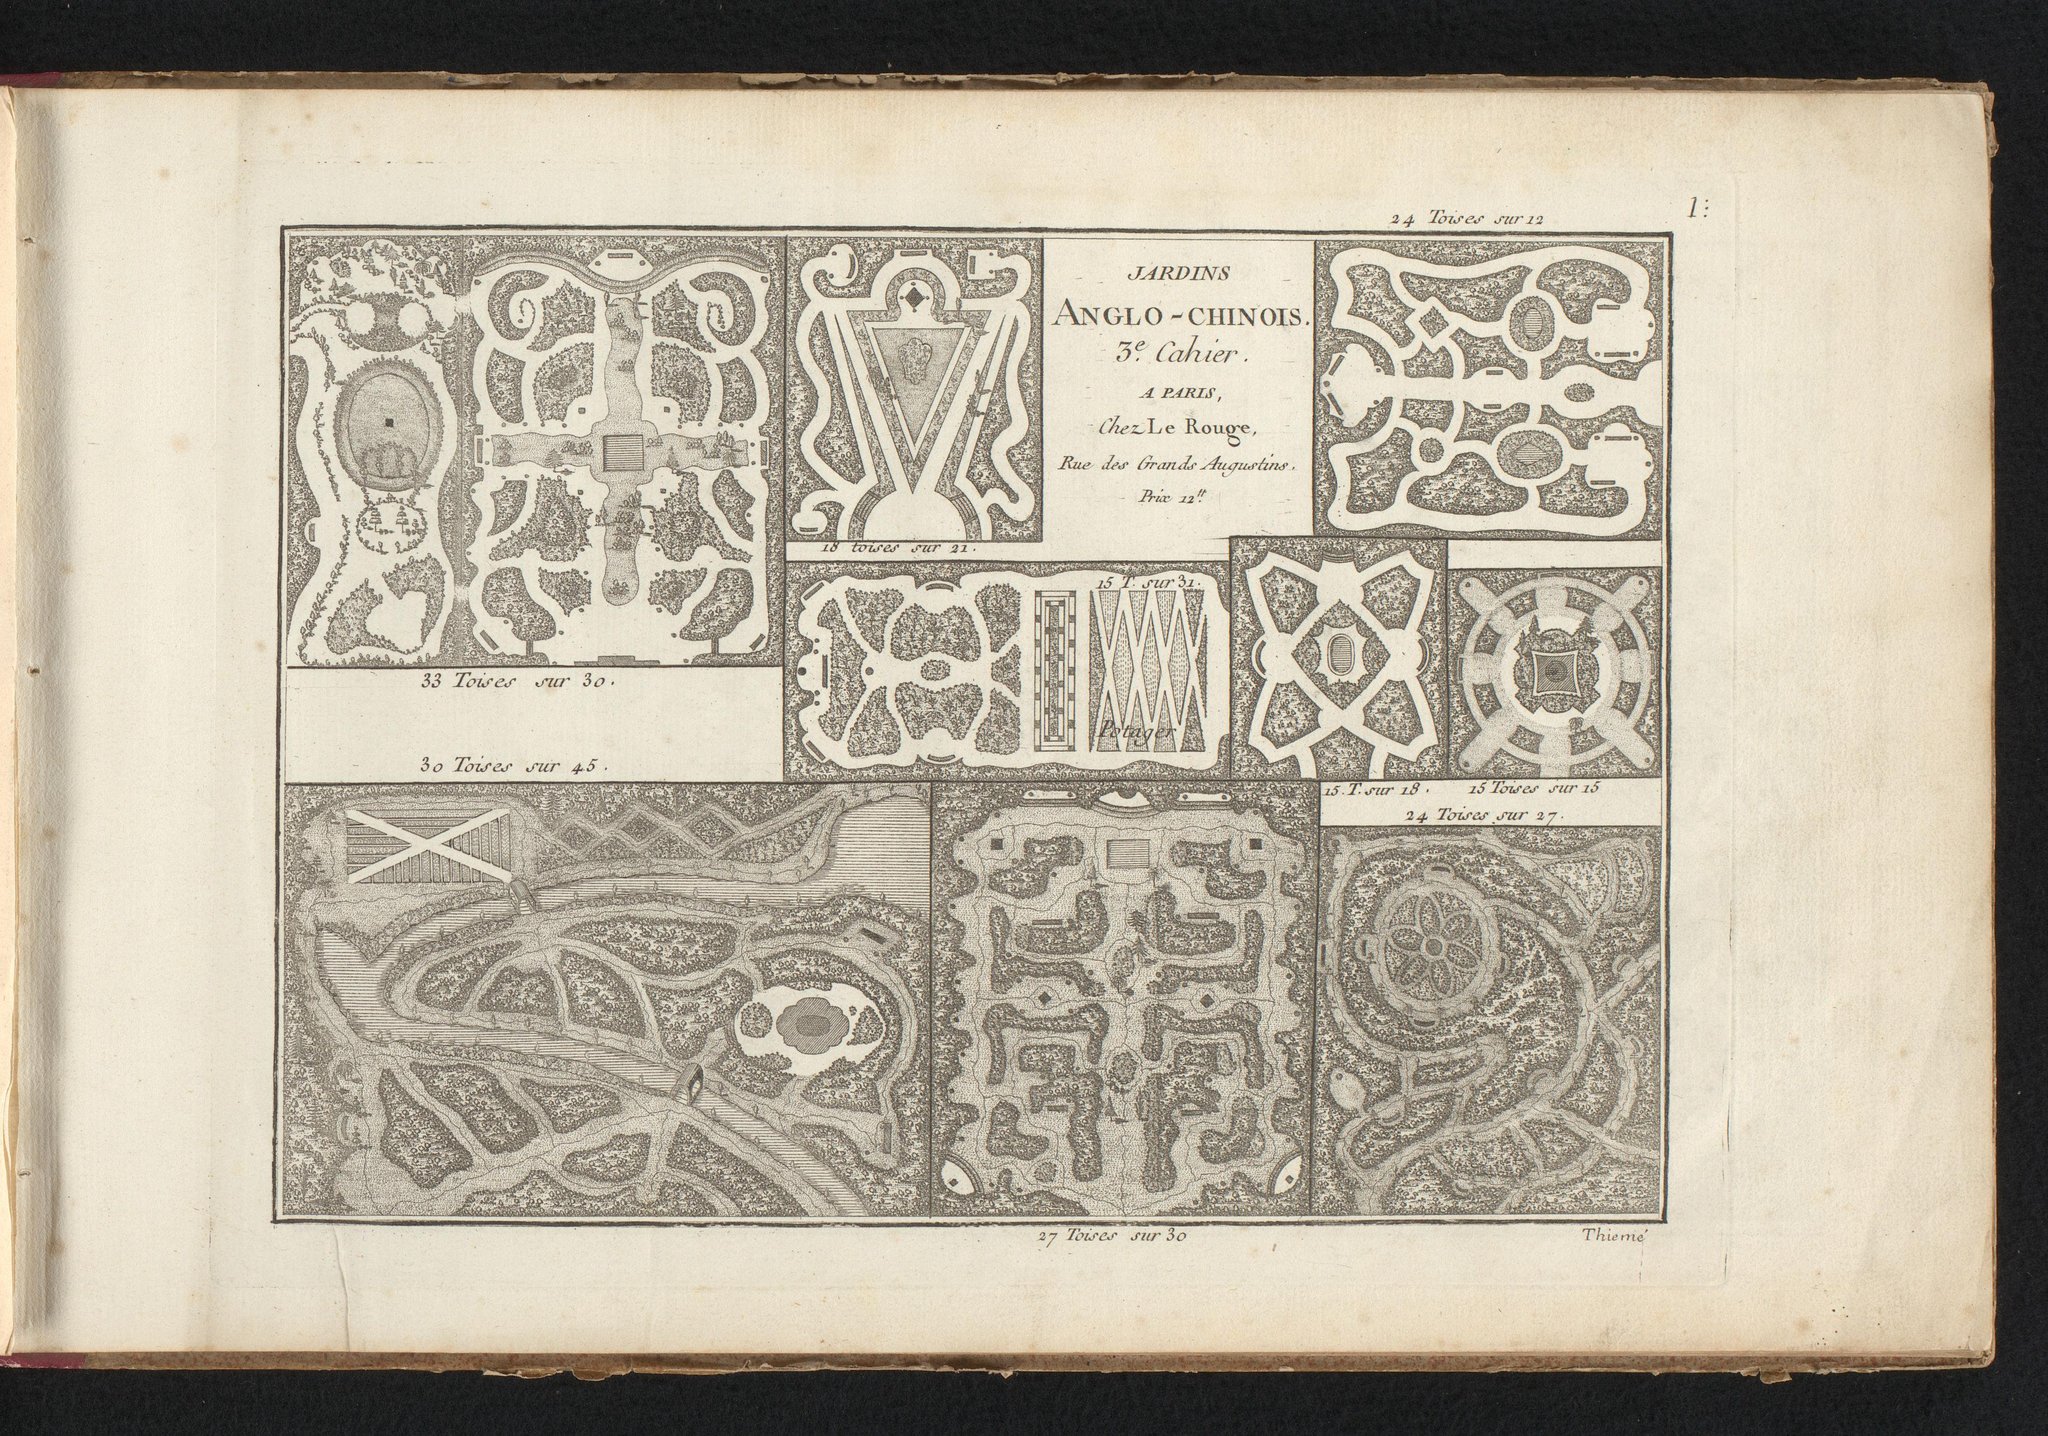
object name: titelprent, frontispice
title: Titelprent voor Jardins Anglo-Chinois, derde cahier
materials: paper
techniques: engraving, etching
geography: paris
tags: plan, map of garden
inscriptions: collector's mark: Lugt 2228, collector's mark: Lugt 2760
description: De serie 'Jardins anglo-chinois à la mode' verscheen in totaal in 21 zogeheten 'cahiers' (afleveringen). De huidige prent komt uit het derde 'cahier'. Het Rijksmuseum Amsterdam bezit drie banden met daarin in totaal zes 'cahiers' van deze reeks. In de documentatie wordt verwezen naar een in de bibliotheek van het Rijksmuseum Amsterdam aanwezige facsimile van het complete werk.